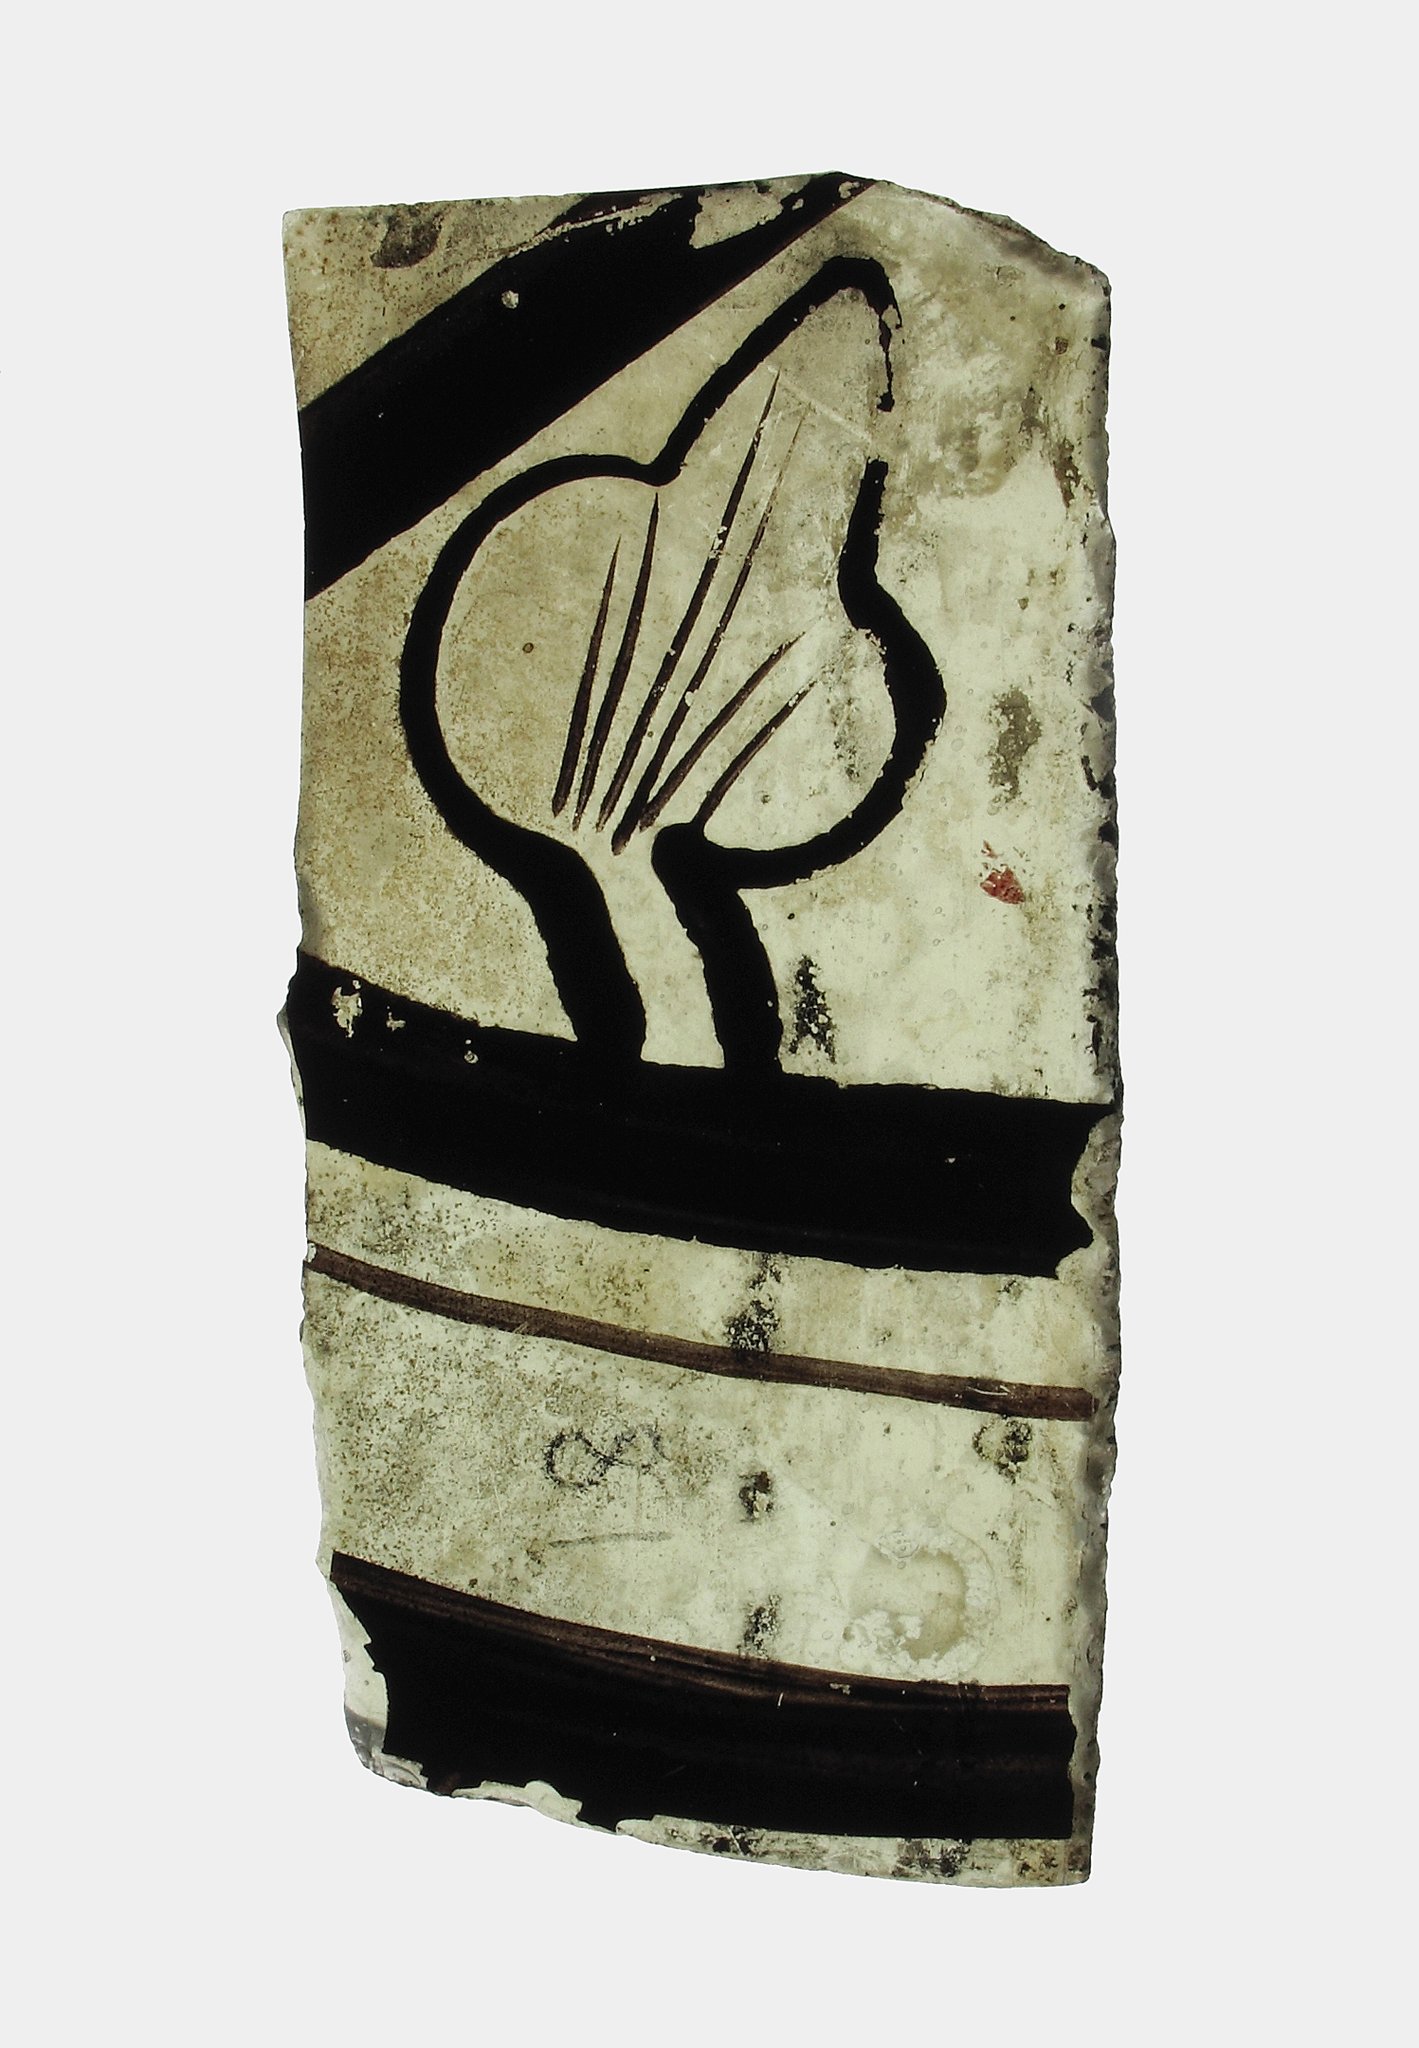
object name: fragment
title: Glass Fragment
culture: french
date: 1301-1400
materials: glass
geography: france